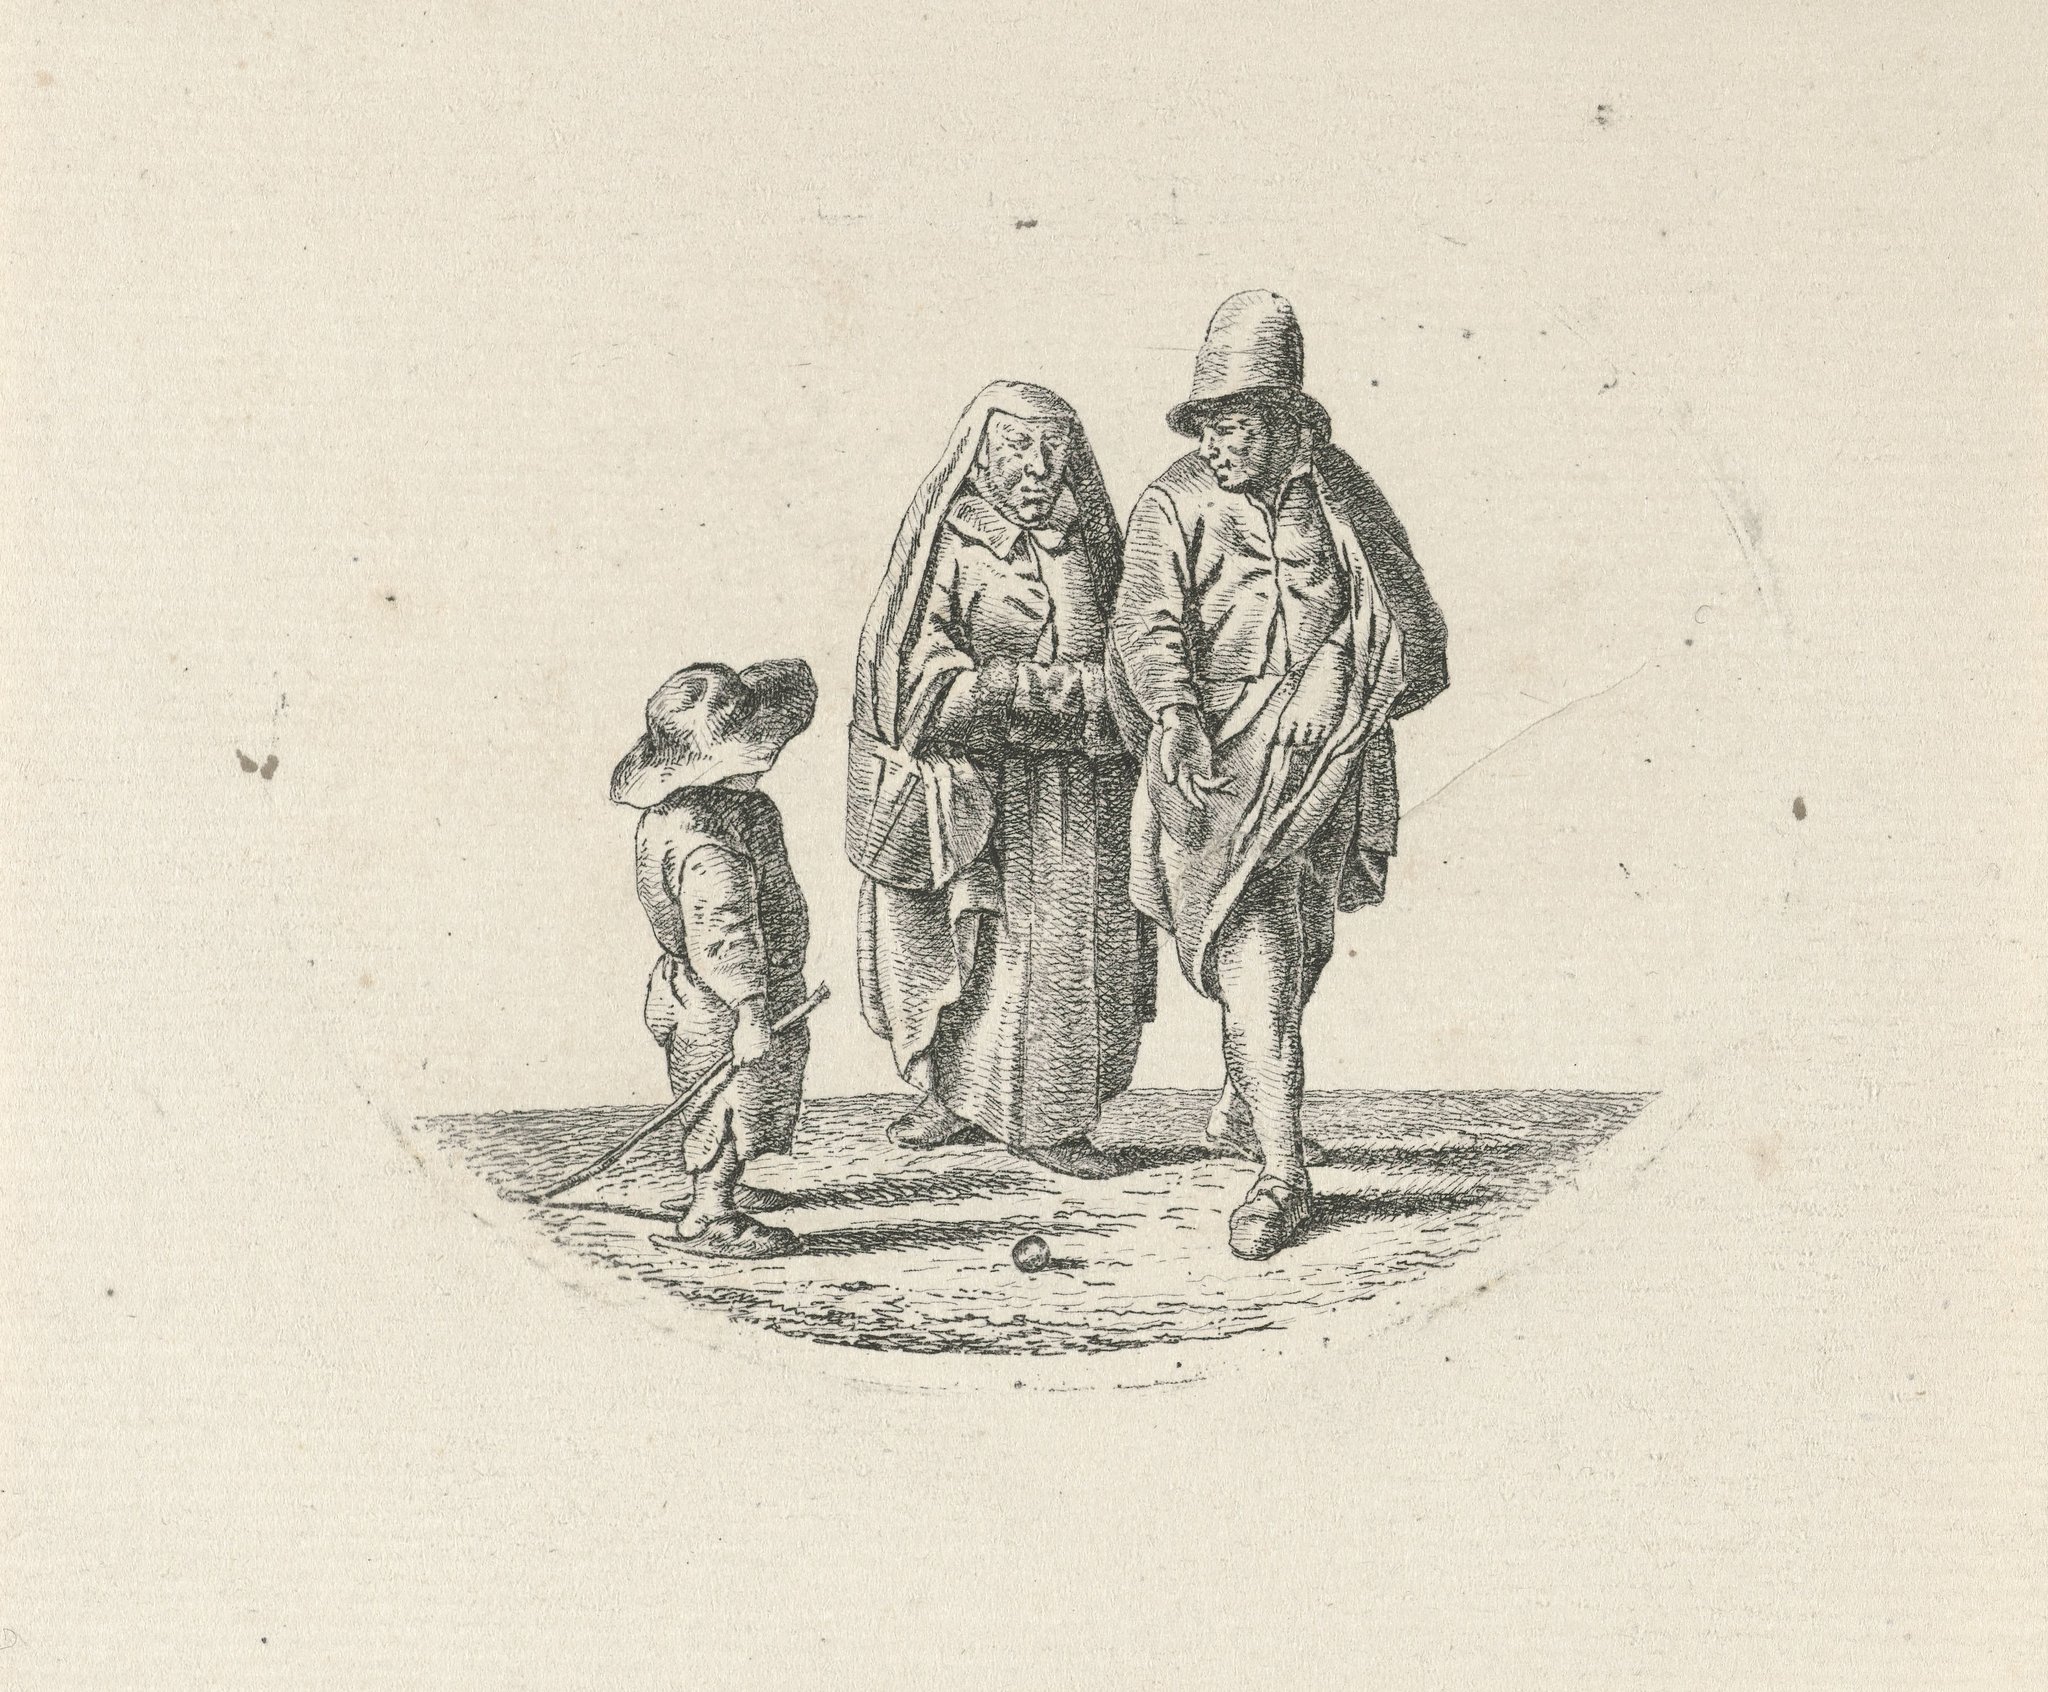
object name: print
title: Man, vrouw en kind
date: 1803-1842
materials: paper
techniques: etching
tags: child (+ sideview, profile), adult man, old woman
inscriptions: collector's mark: Lugt 2228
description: Een man wijst naar een bal op de grond, waar een kind, met stok in hand, naar kijkt. Achter hem een oudere vrouw.